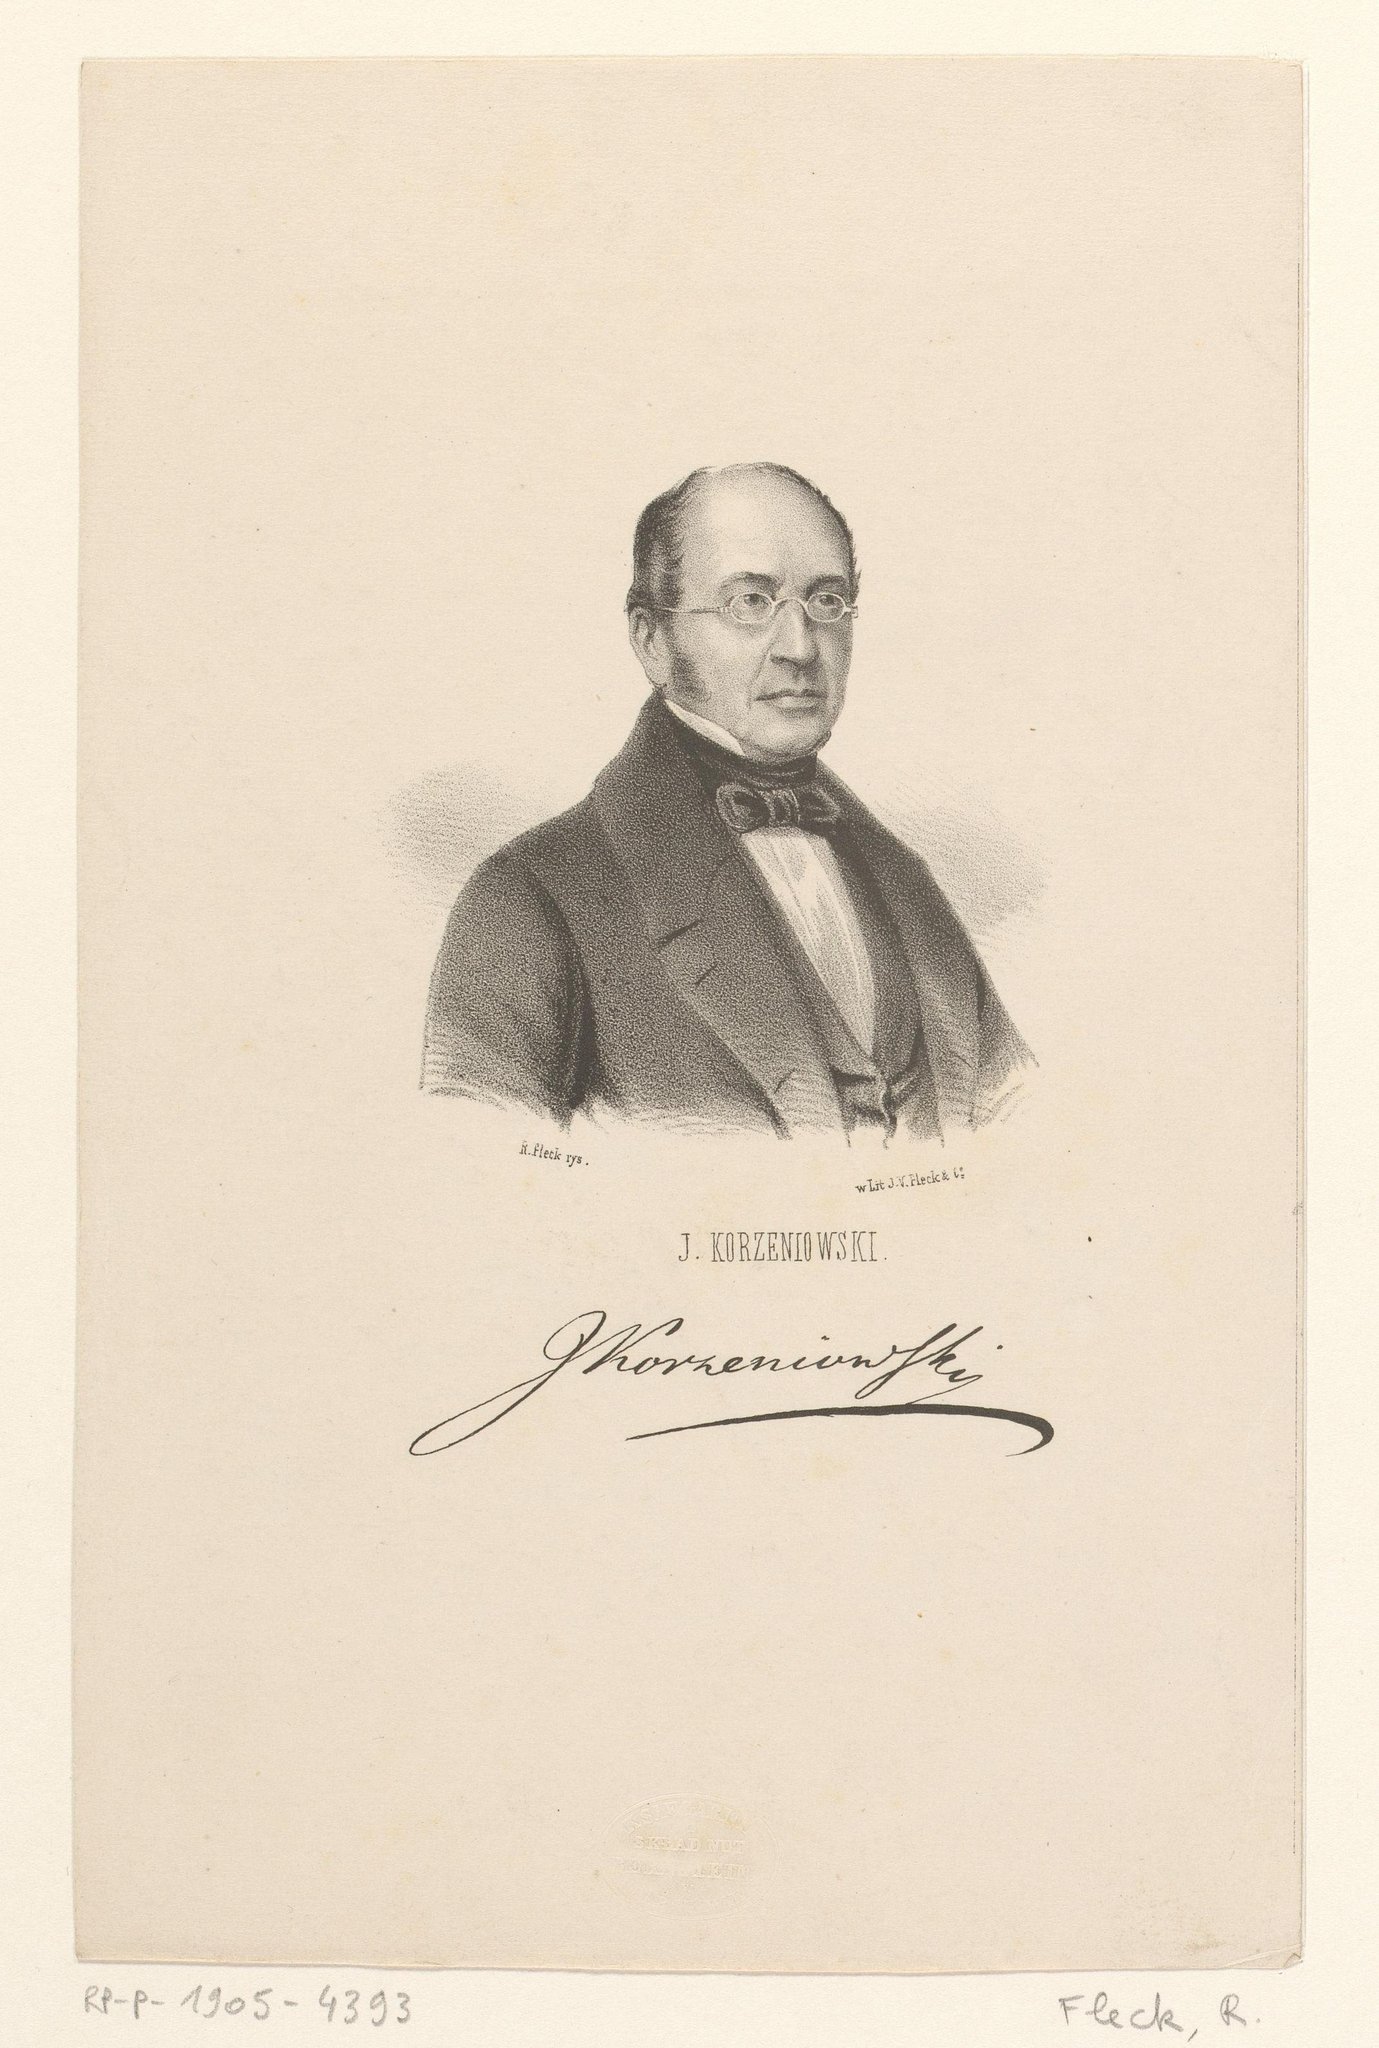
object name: print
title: Portret van Józef Korzeniowski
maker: rudolf fleck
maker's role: print maker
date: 1820-1860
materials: paper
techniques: lithograph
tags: eyeglasses, spectacles, adult man, historical persons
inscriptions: collector's mark: Lugt 2228, check stamp: ‘Skiegarn[...] Sklad nut Bernstein w warszawie’